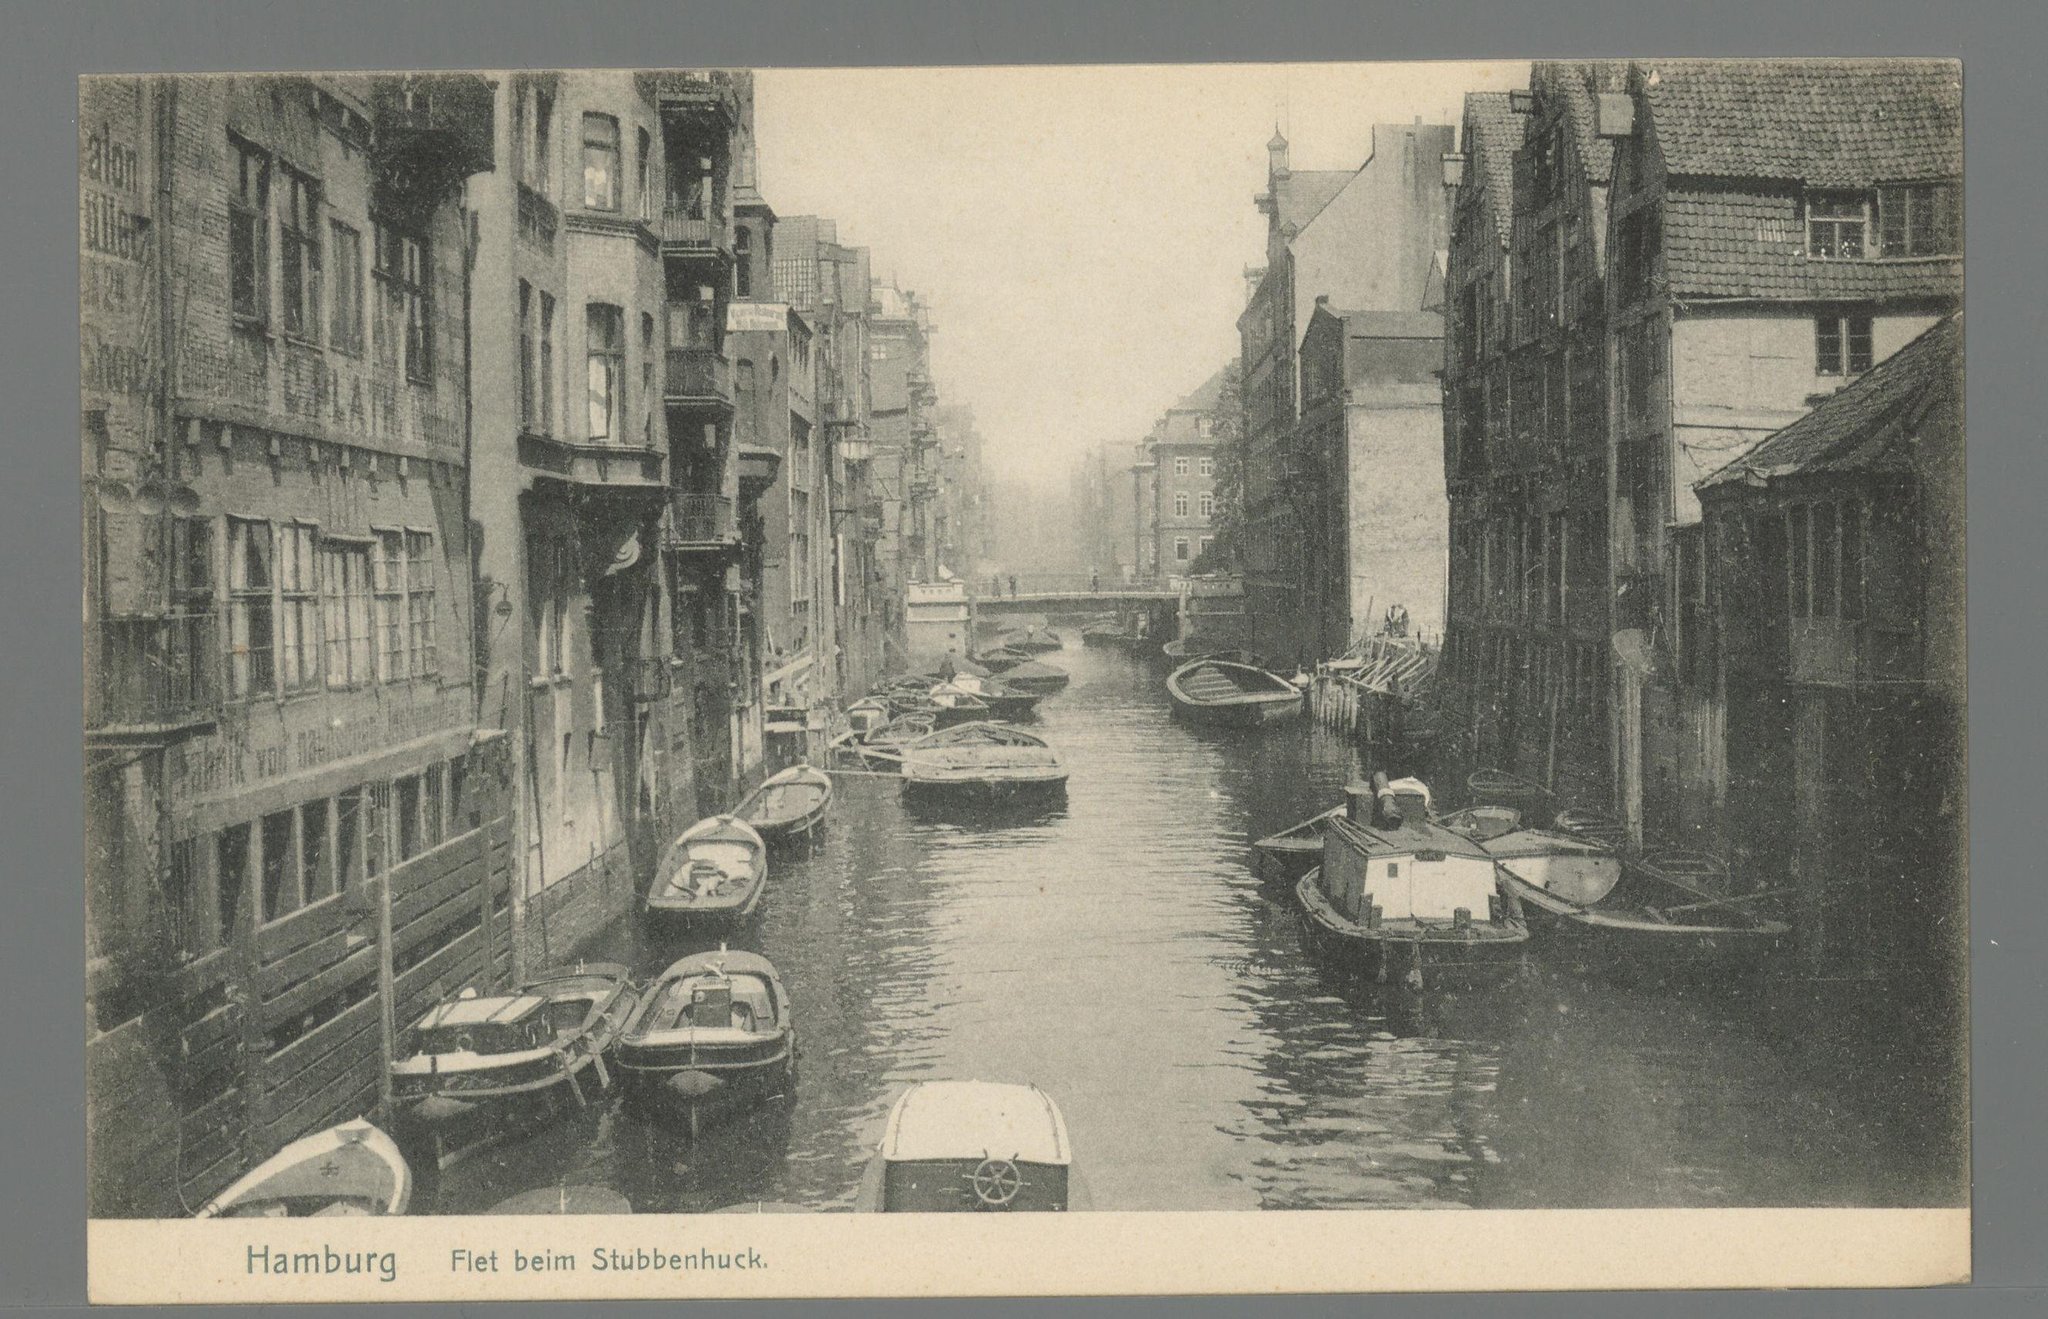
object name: photomechanical print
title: Hamburg. Flet beim Stubbenhuck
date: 1905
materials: cardboard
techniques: photograph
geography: hamburg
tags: canals, waters (in city), bridge in city across river, canal, etc., street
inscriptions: date